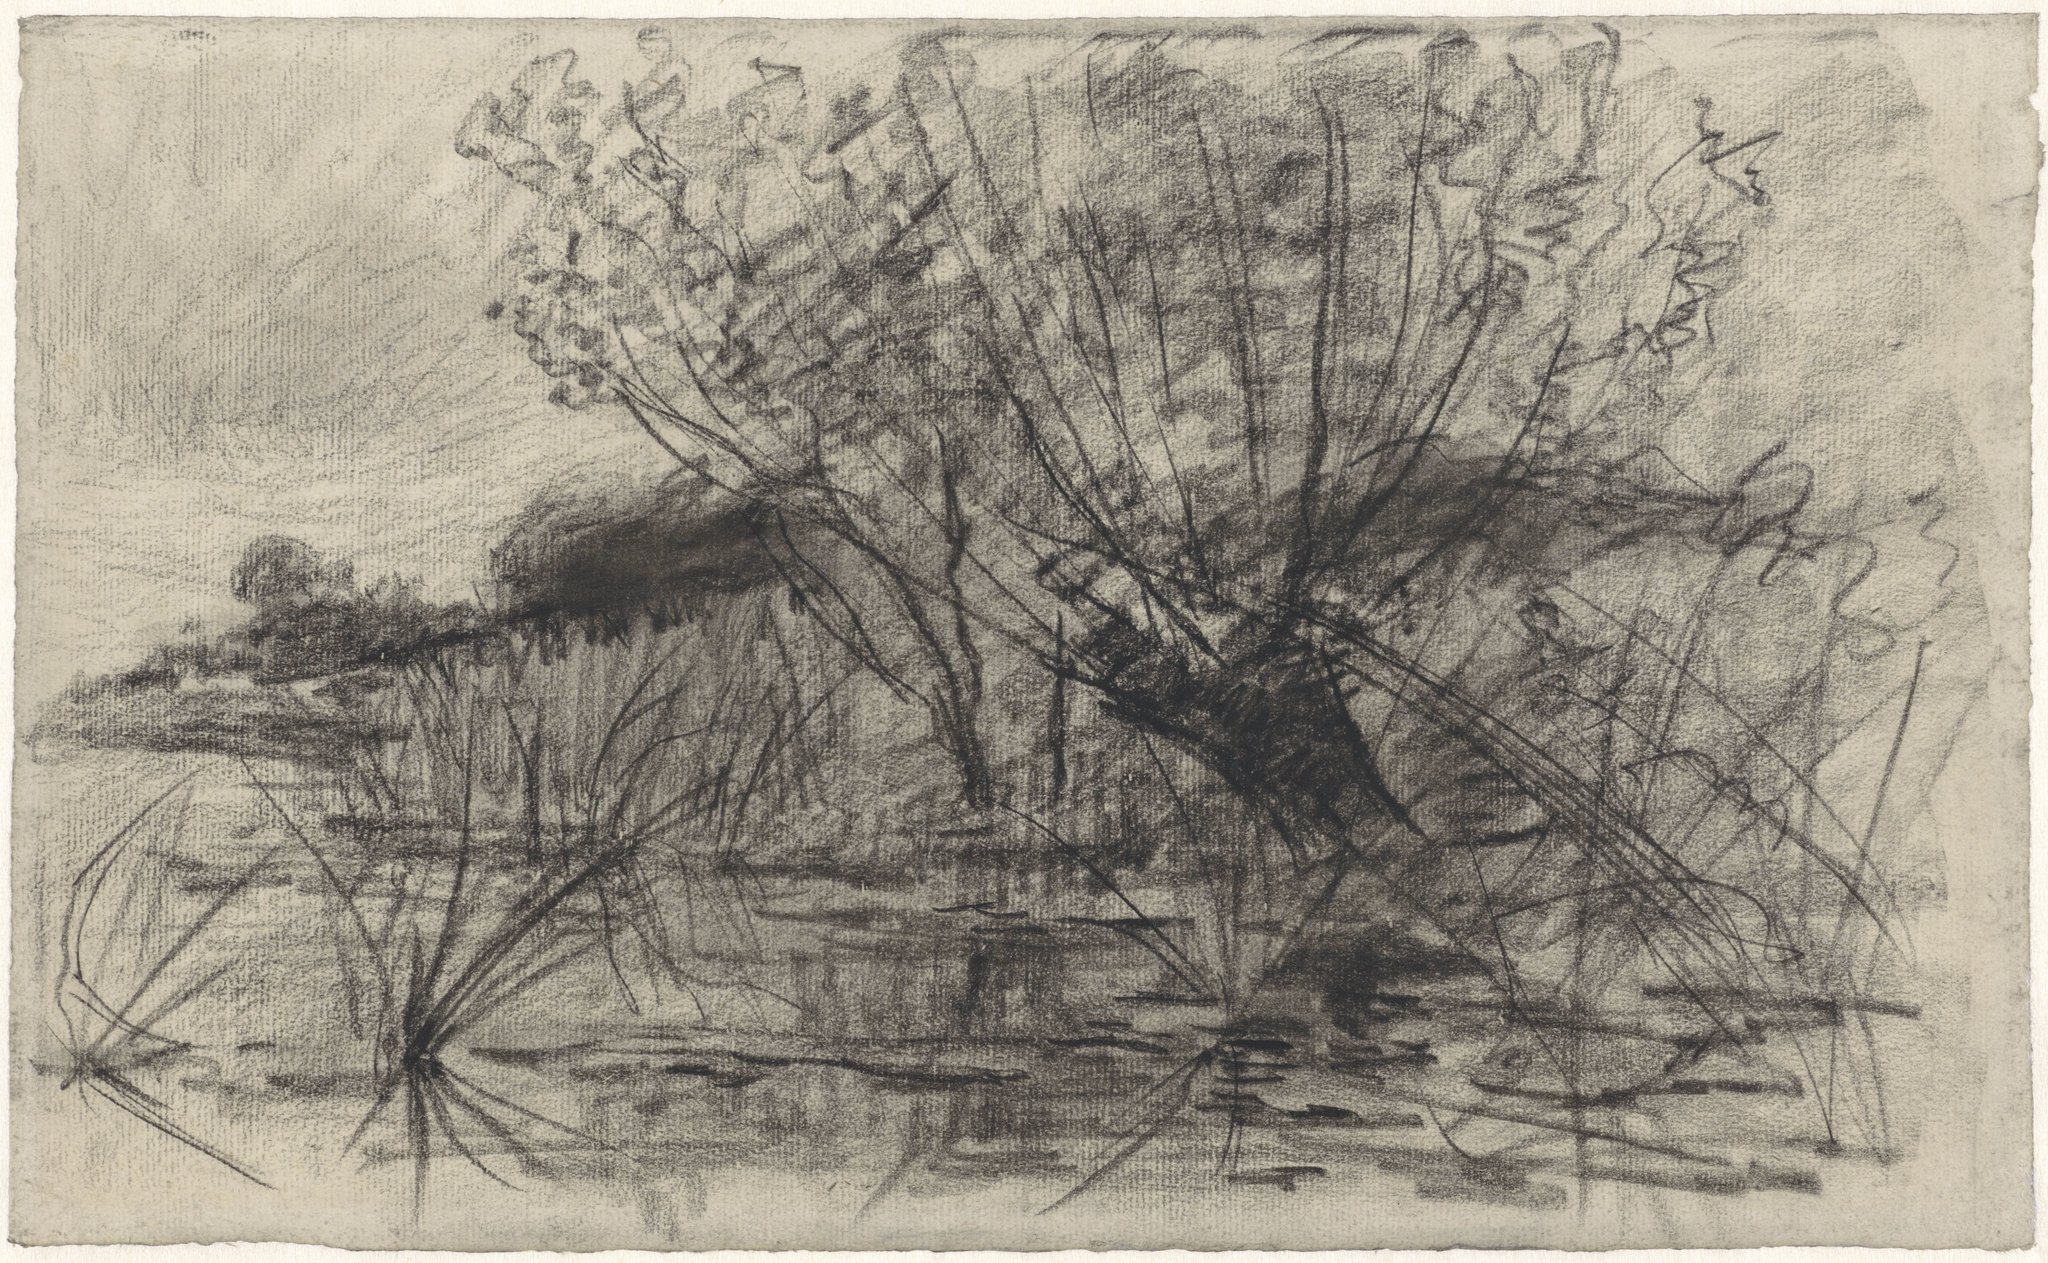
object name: drawing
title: Knotwilg aan het water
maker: egbert rubertus derk schaap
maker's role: draughtsman, painter, print maker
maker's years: 1862-1939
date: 1872-1939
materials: chalk, paper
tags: trees: pollard willow, small canal, ditch